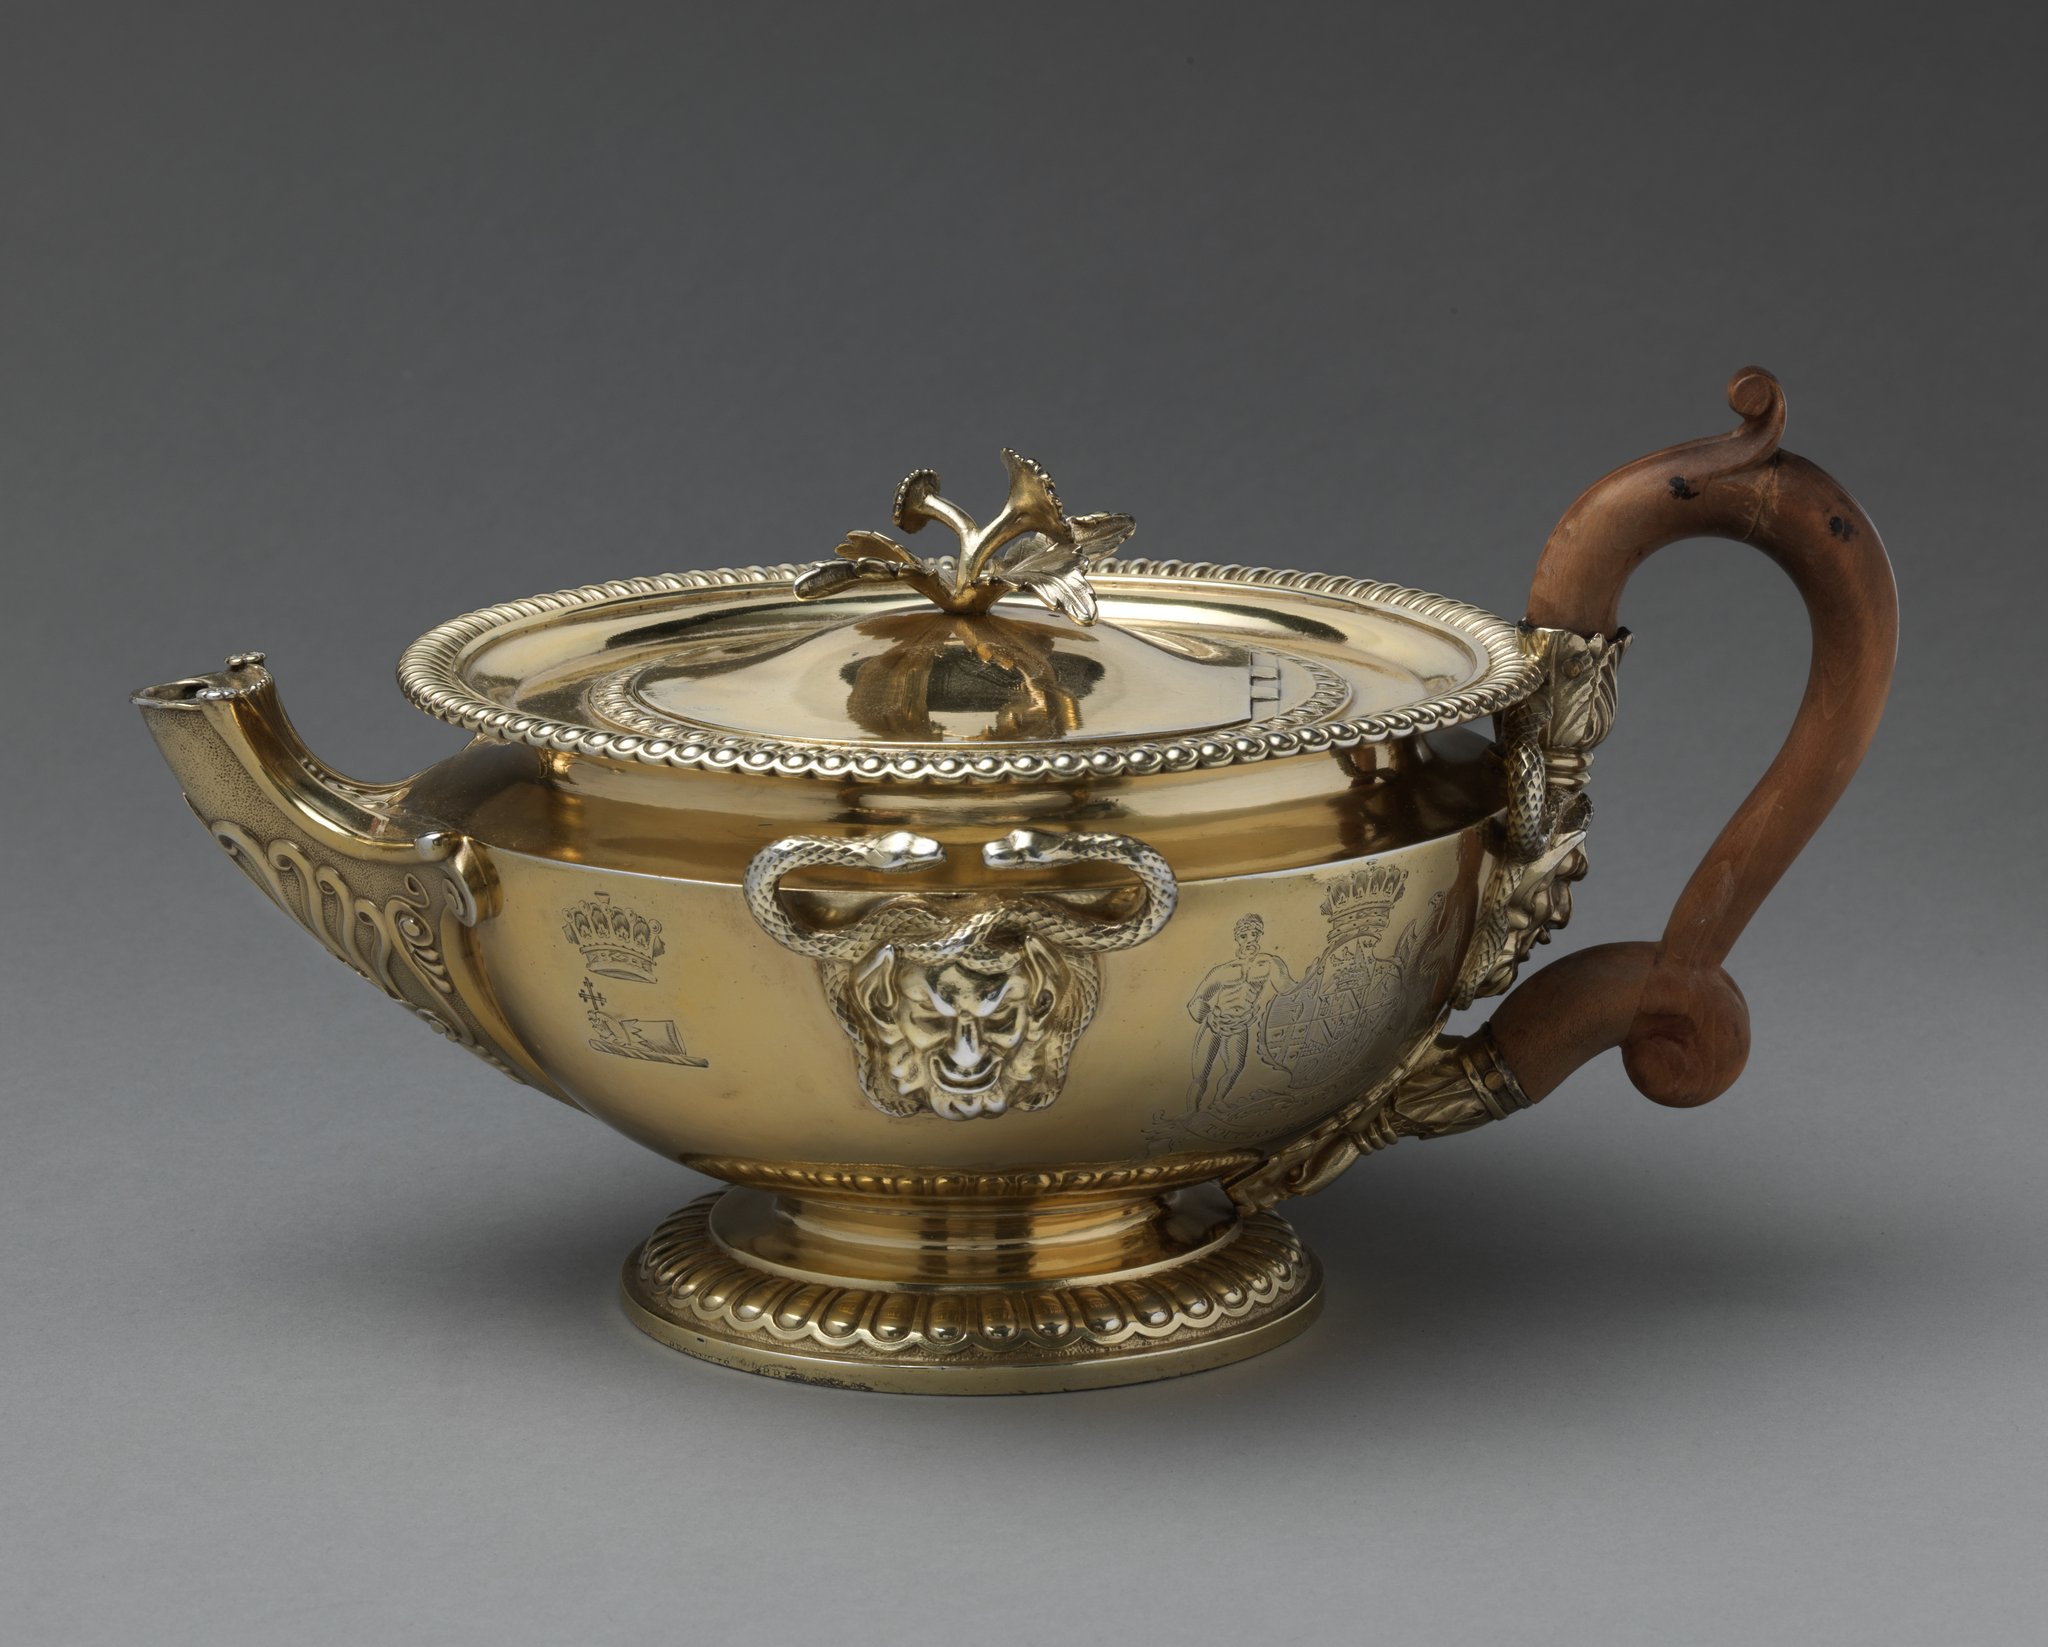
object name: teapot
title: Teapot (part of a set)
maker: paul storr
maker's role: maker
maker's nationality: british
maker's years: 1771-1844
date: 1813-1814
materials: silver gilt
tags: masks,men,coat of arms